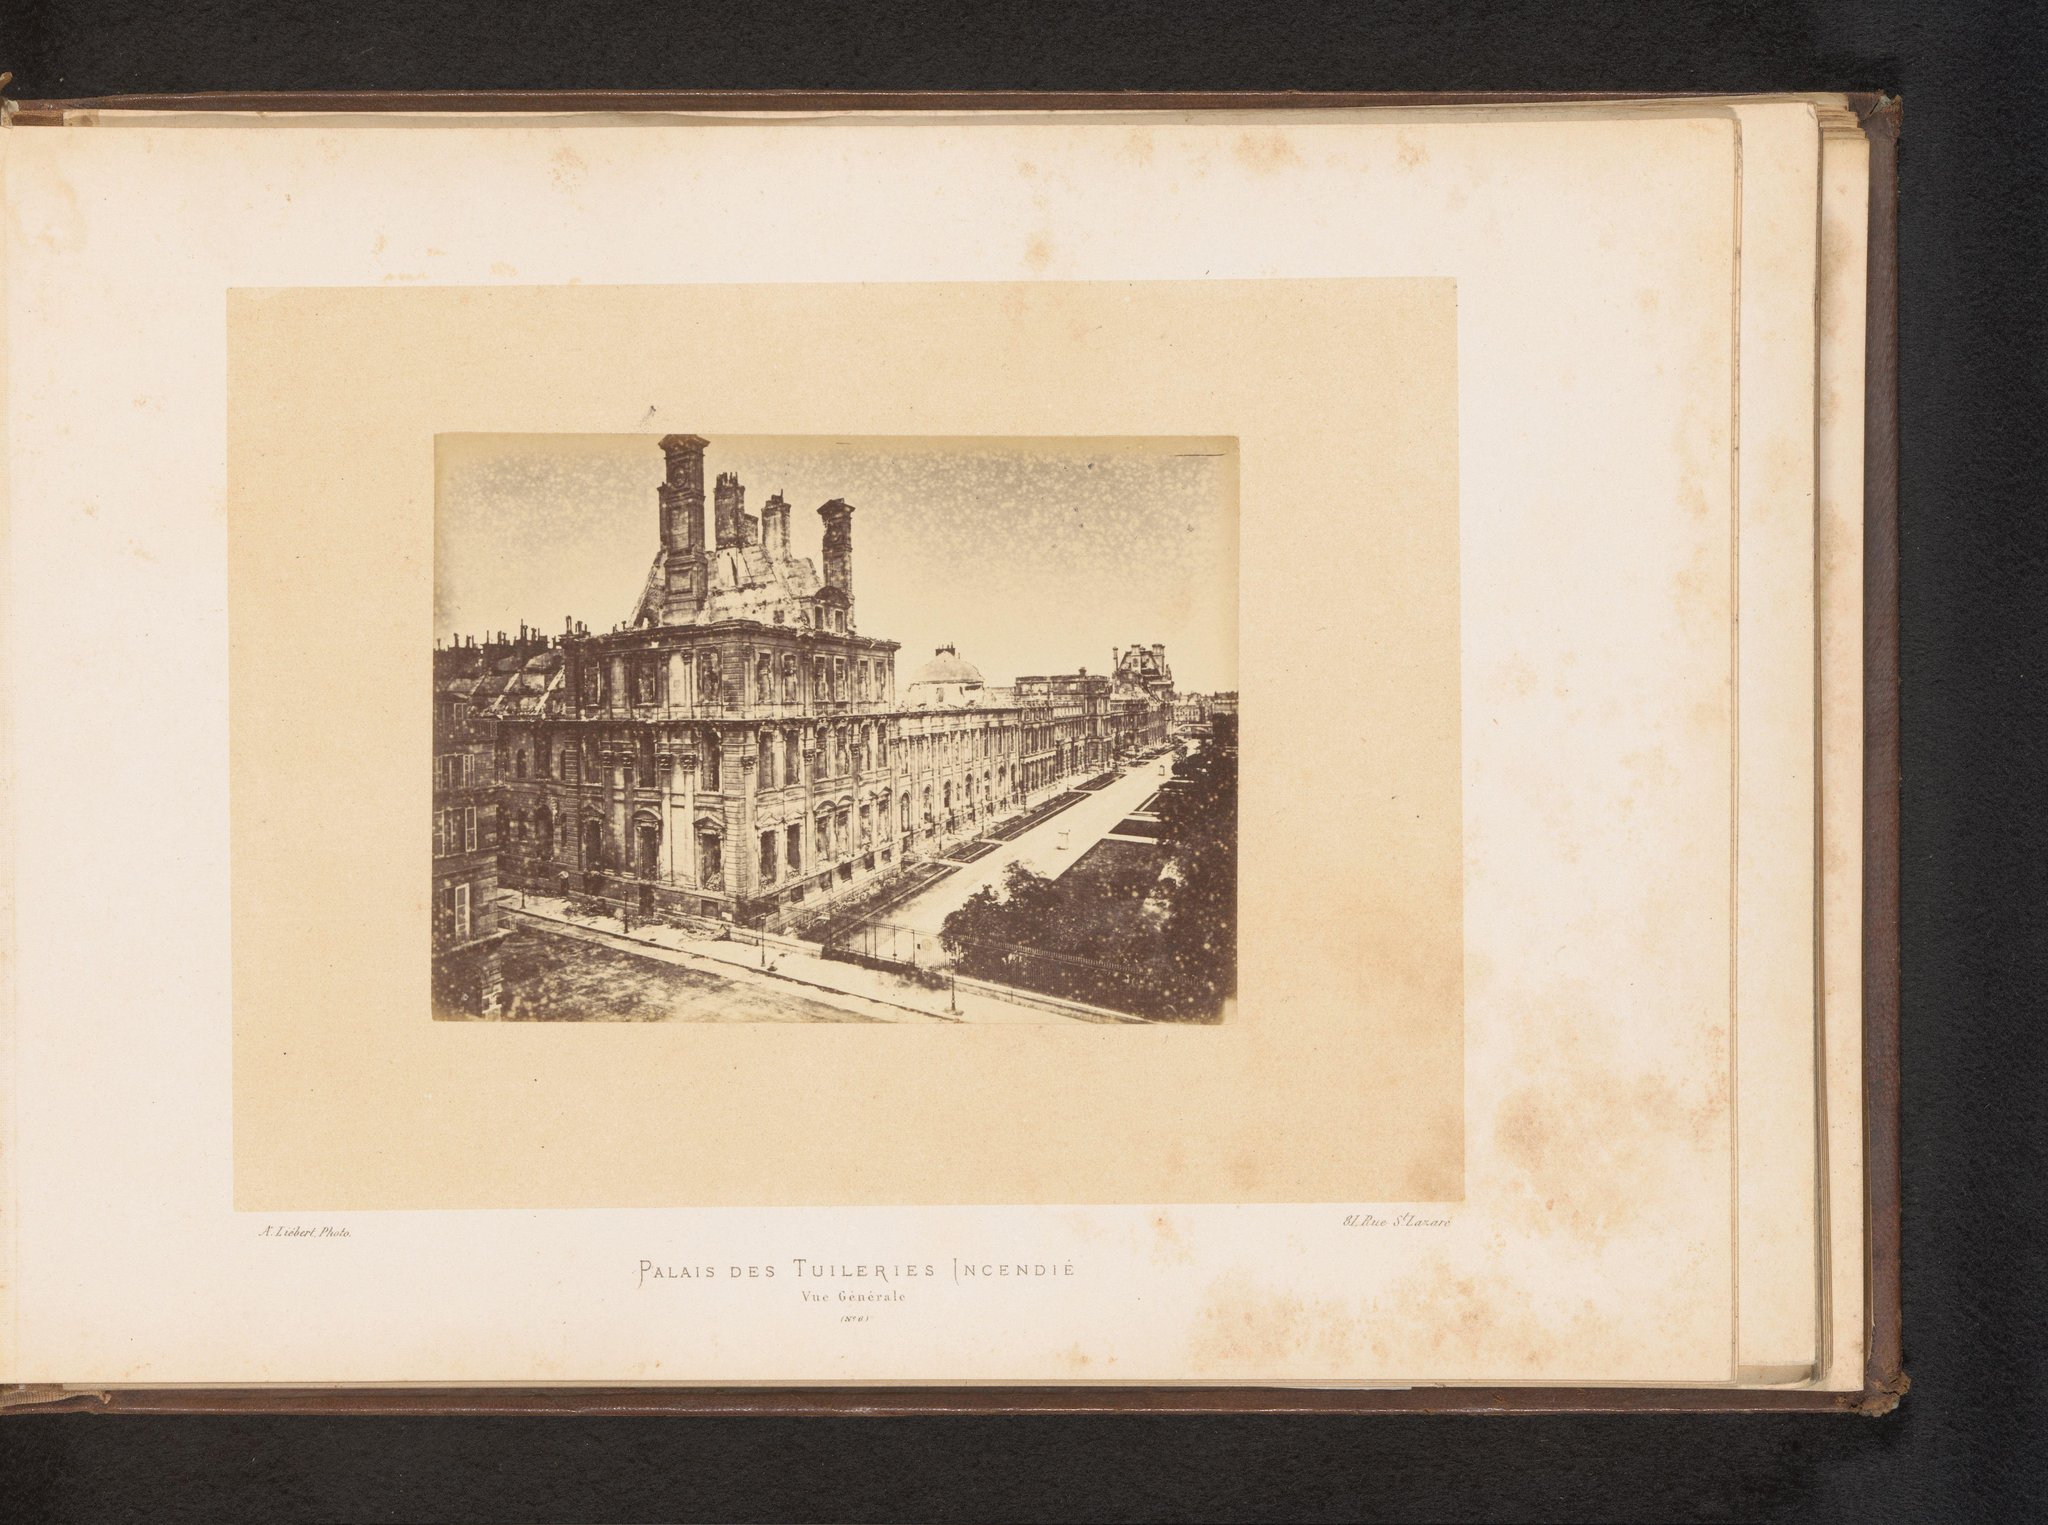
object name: page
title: Palais des Tuileries Incendié. Vue Générale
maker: alphonse-justin liébert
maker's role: fotograaf, marinier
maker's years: 1827-1914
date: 1871-1872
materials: photographic support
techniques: albumen print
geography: paris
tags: ruin of a building ~ architecture, palace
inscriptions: address: ‘31, Rue St. Lazare’, number: ‘(No. 6)’